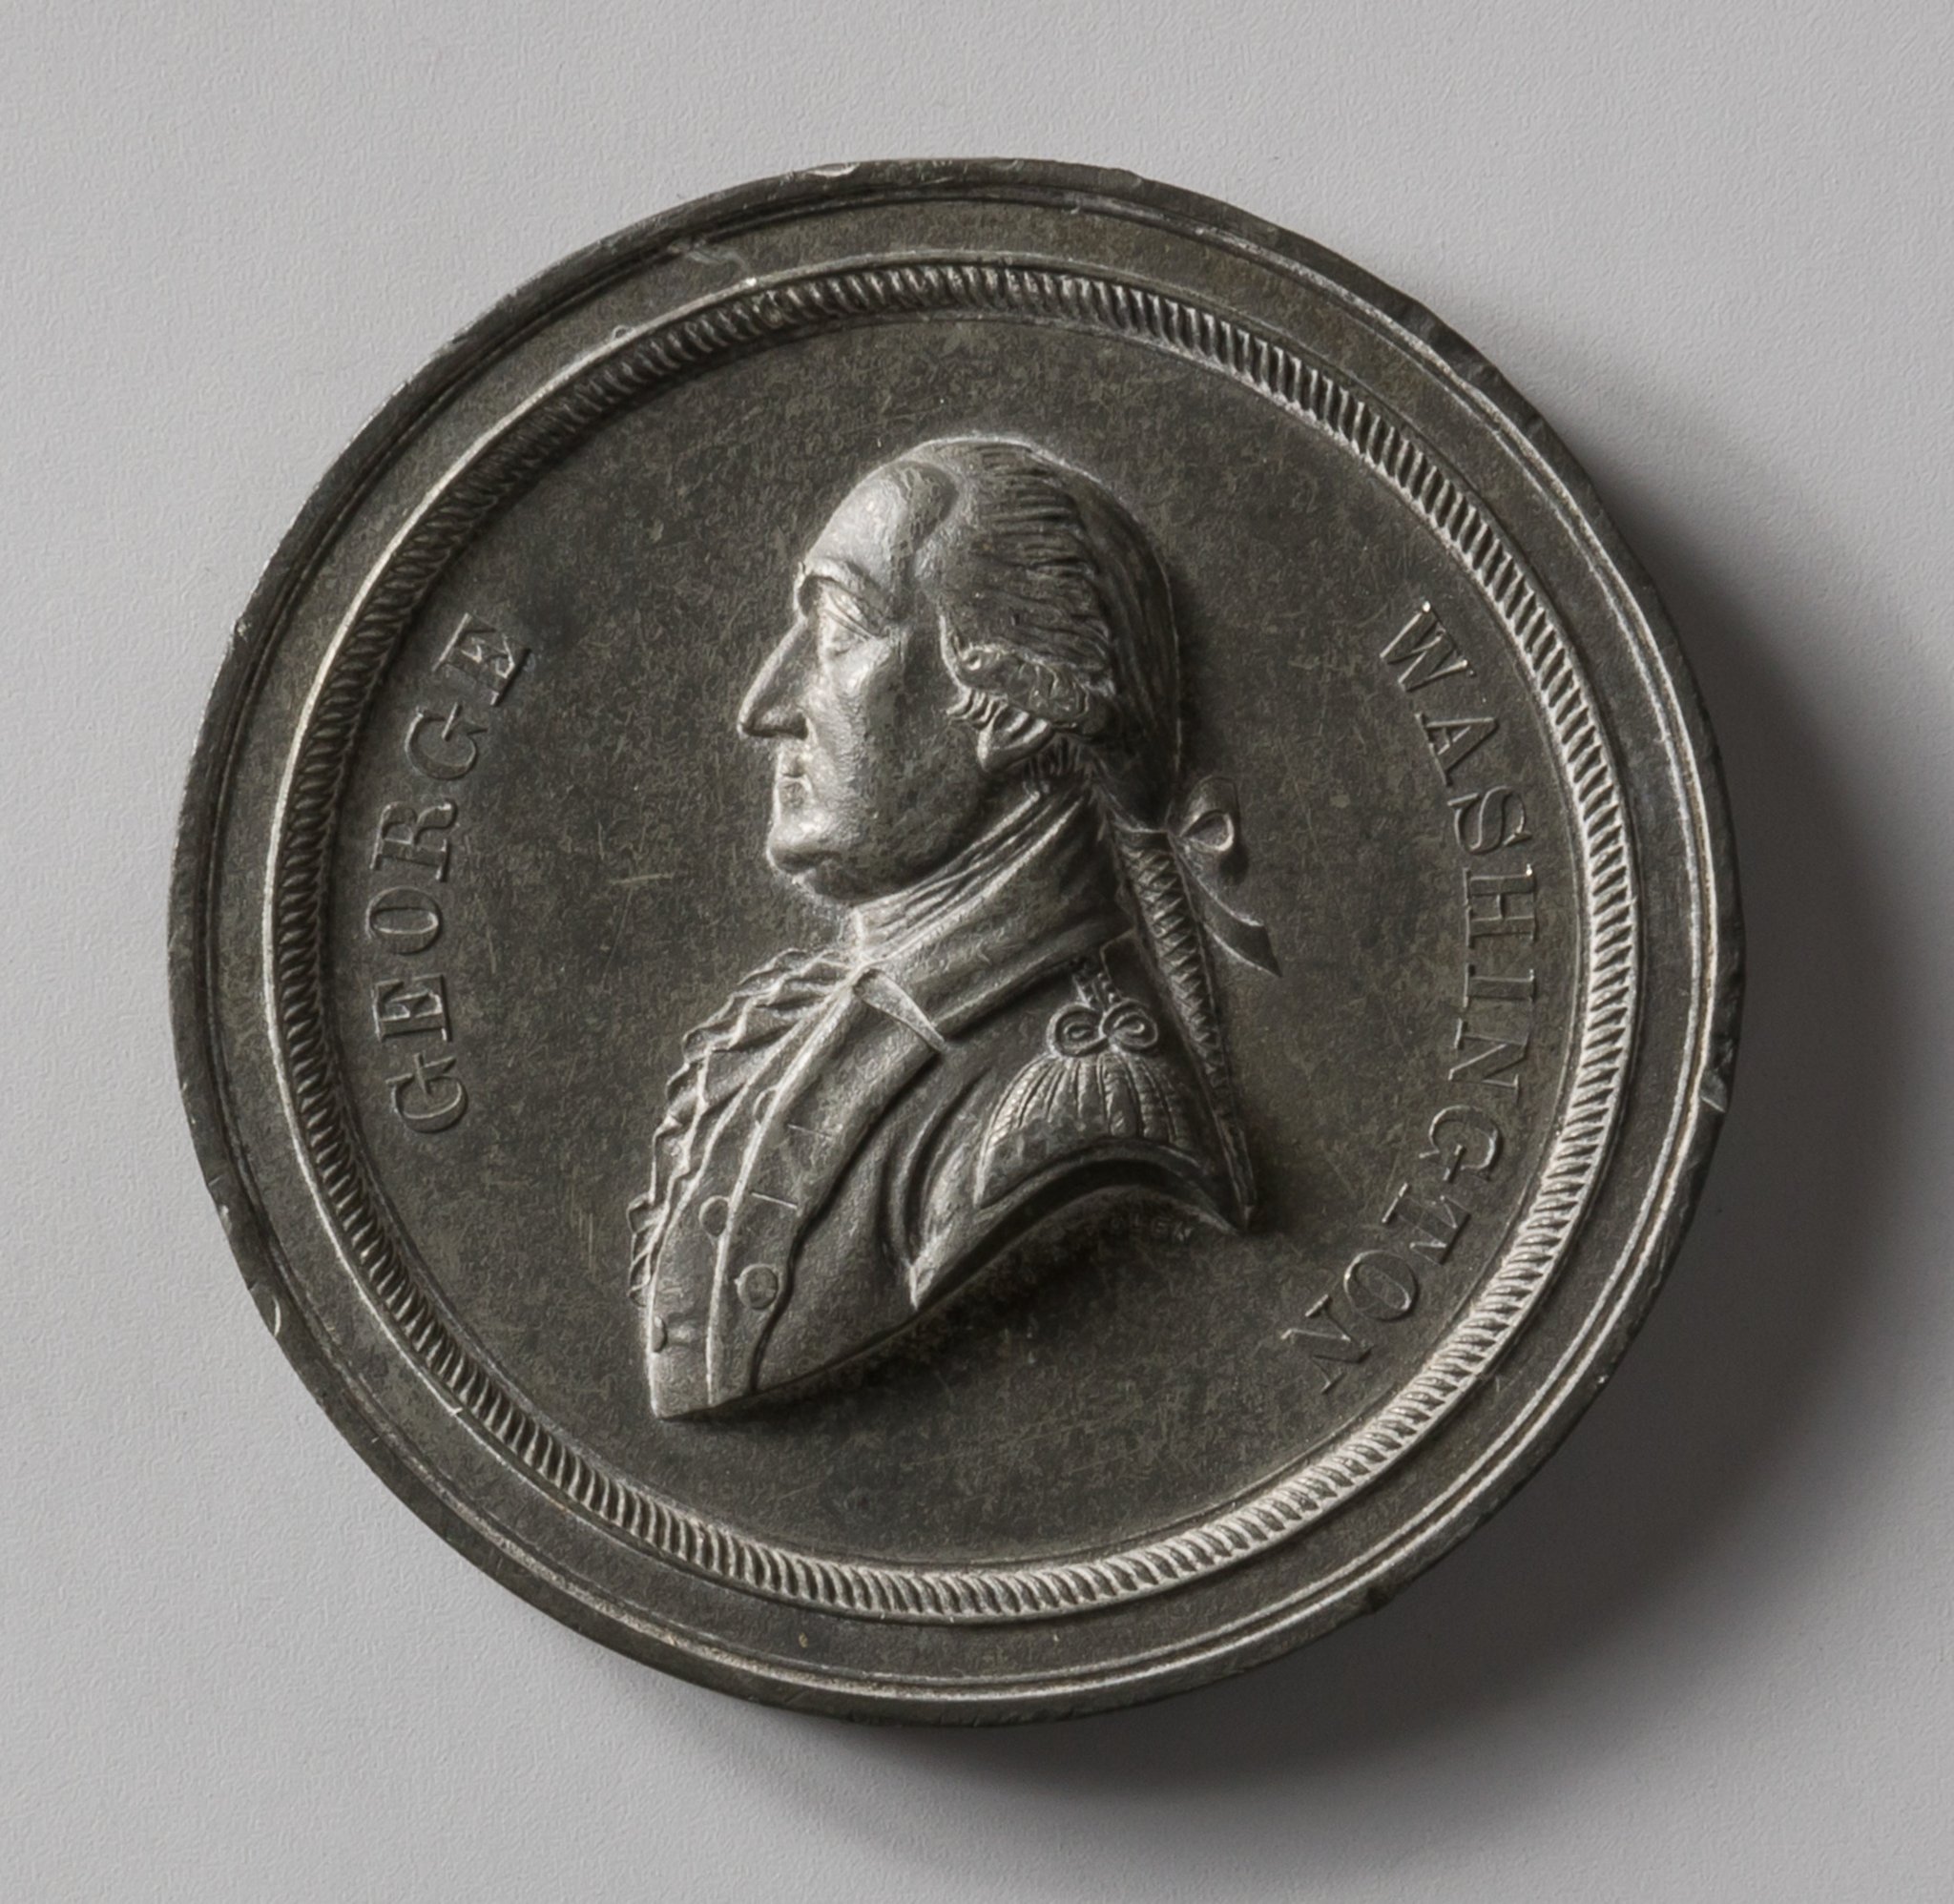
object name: medal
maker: john a. bolen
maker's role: maker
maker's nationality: american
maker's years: 1826-1906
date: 1870-1900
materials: metal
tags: george washington,portraits,profiles